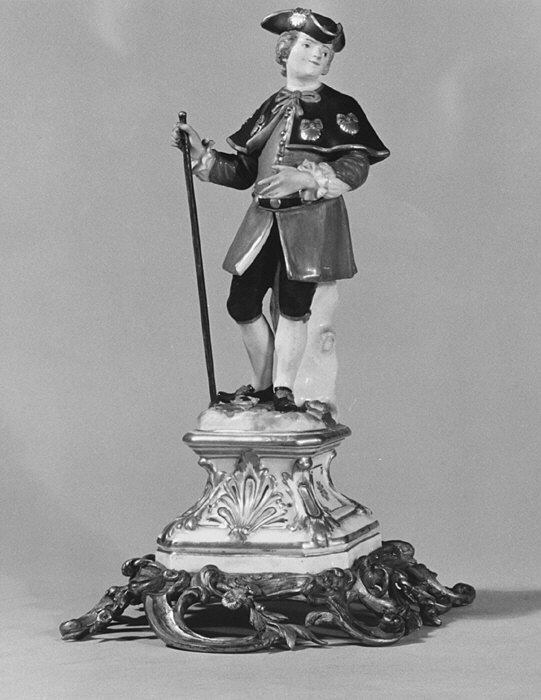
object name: figure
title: Standing man (one of a pair)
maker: meissen manufactory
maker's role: manufactory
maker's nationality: german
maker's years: 1710-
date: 1745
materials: gilt bronze, hard paste porcelain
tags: men